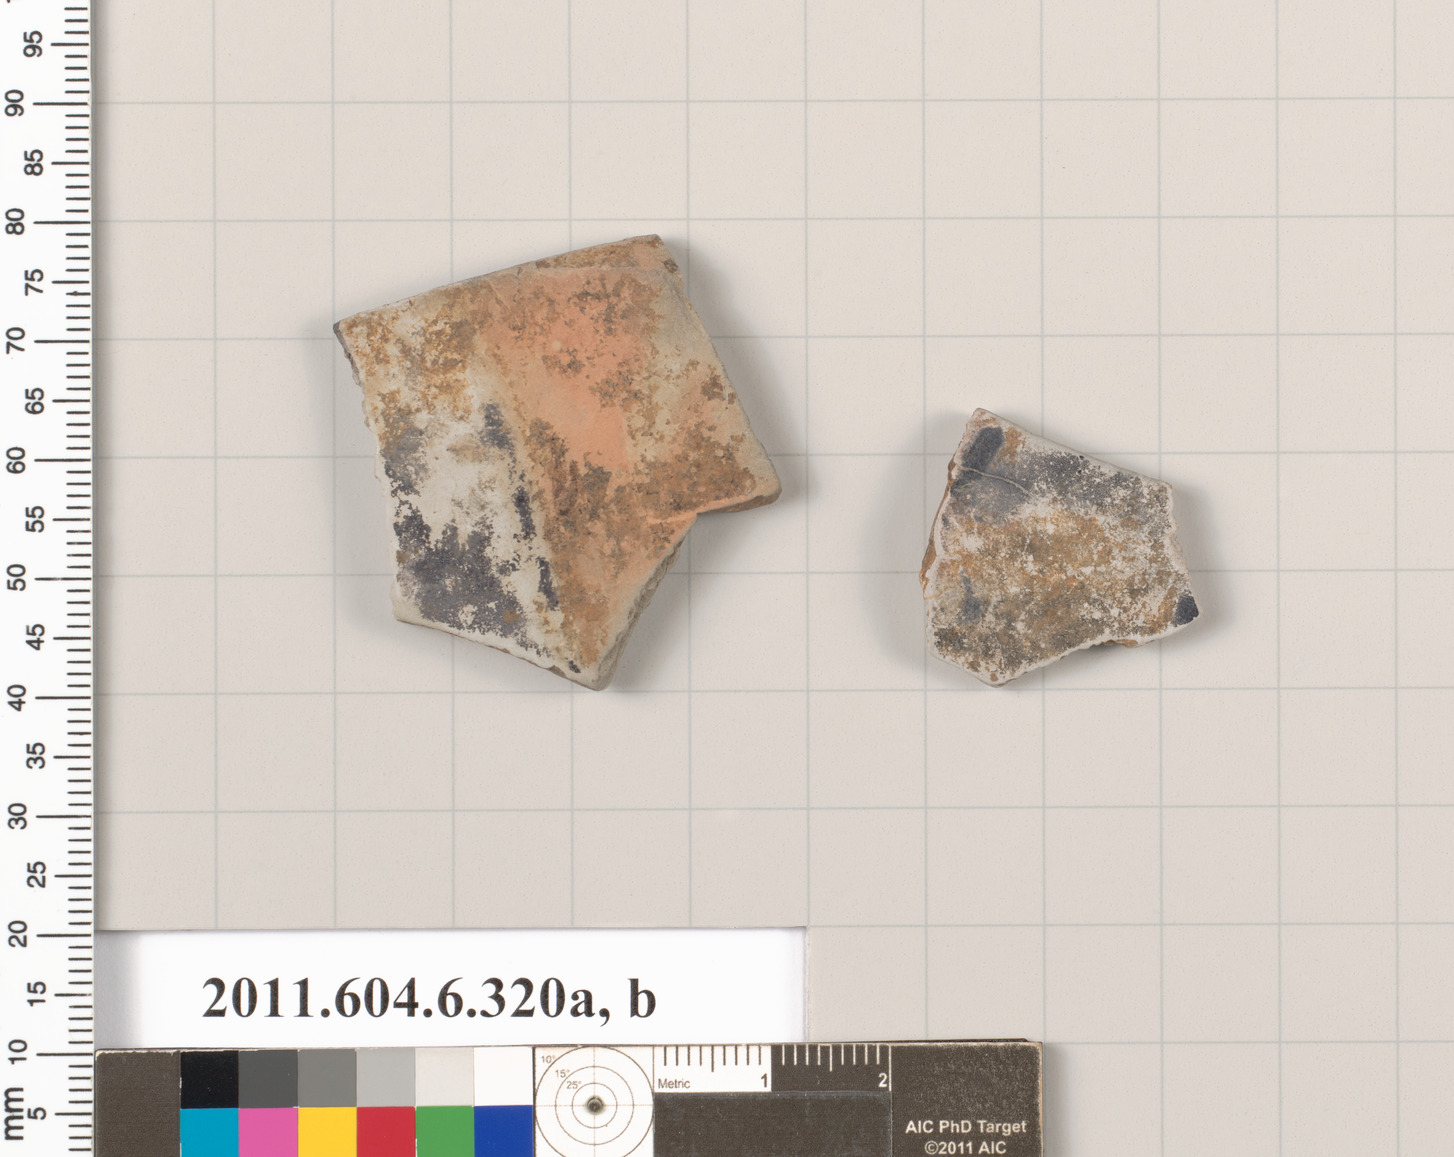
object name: undetermined shape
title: Terracotta fragments of undetermined shapes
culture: greek, attic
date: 600-401 BCE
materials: terracotta